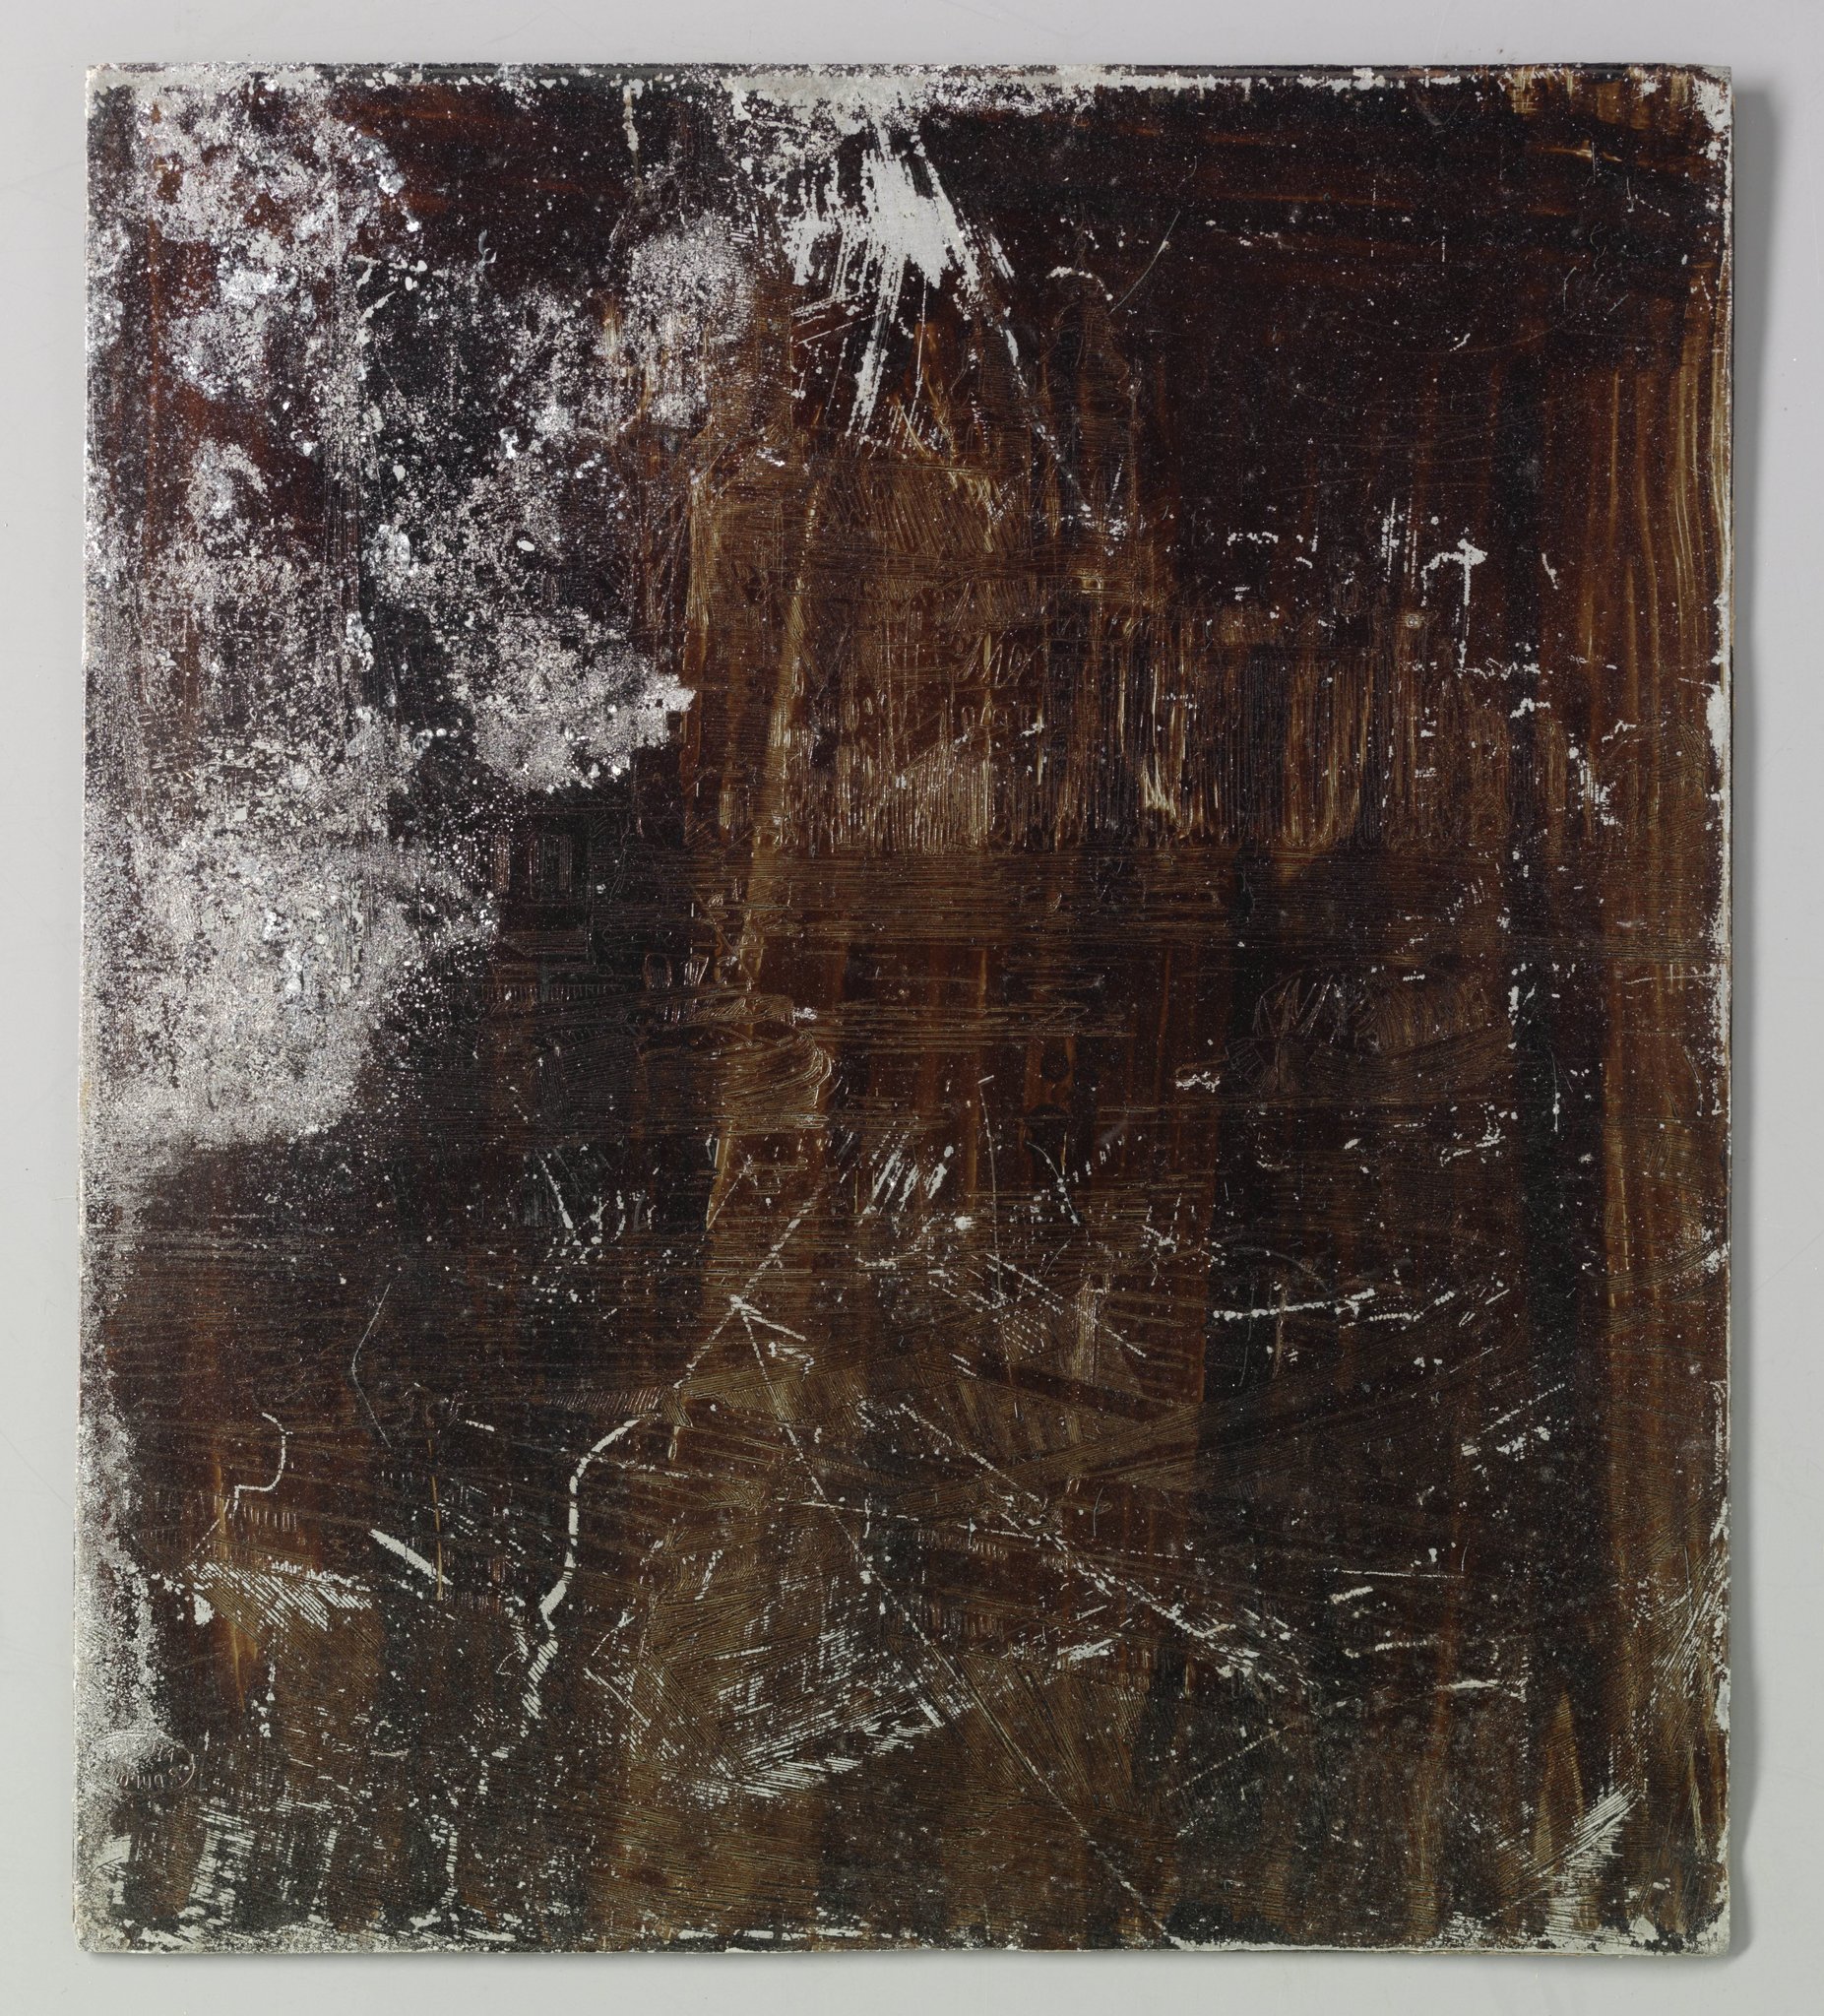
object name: zinkplaat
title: St. Nicolaaskerk te Amsterdam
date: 1894-1895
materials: zinc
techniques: etching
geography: netherlands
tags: amsterdam